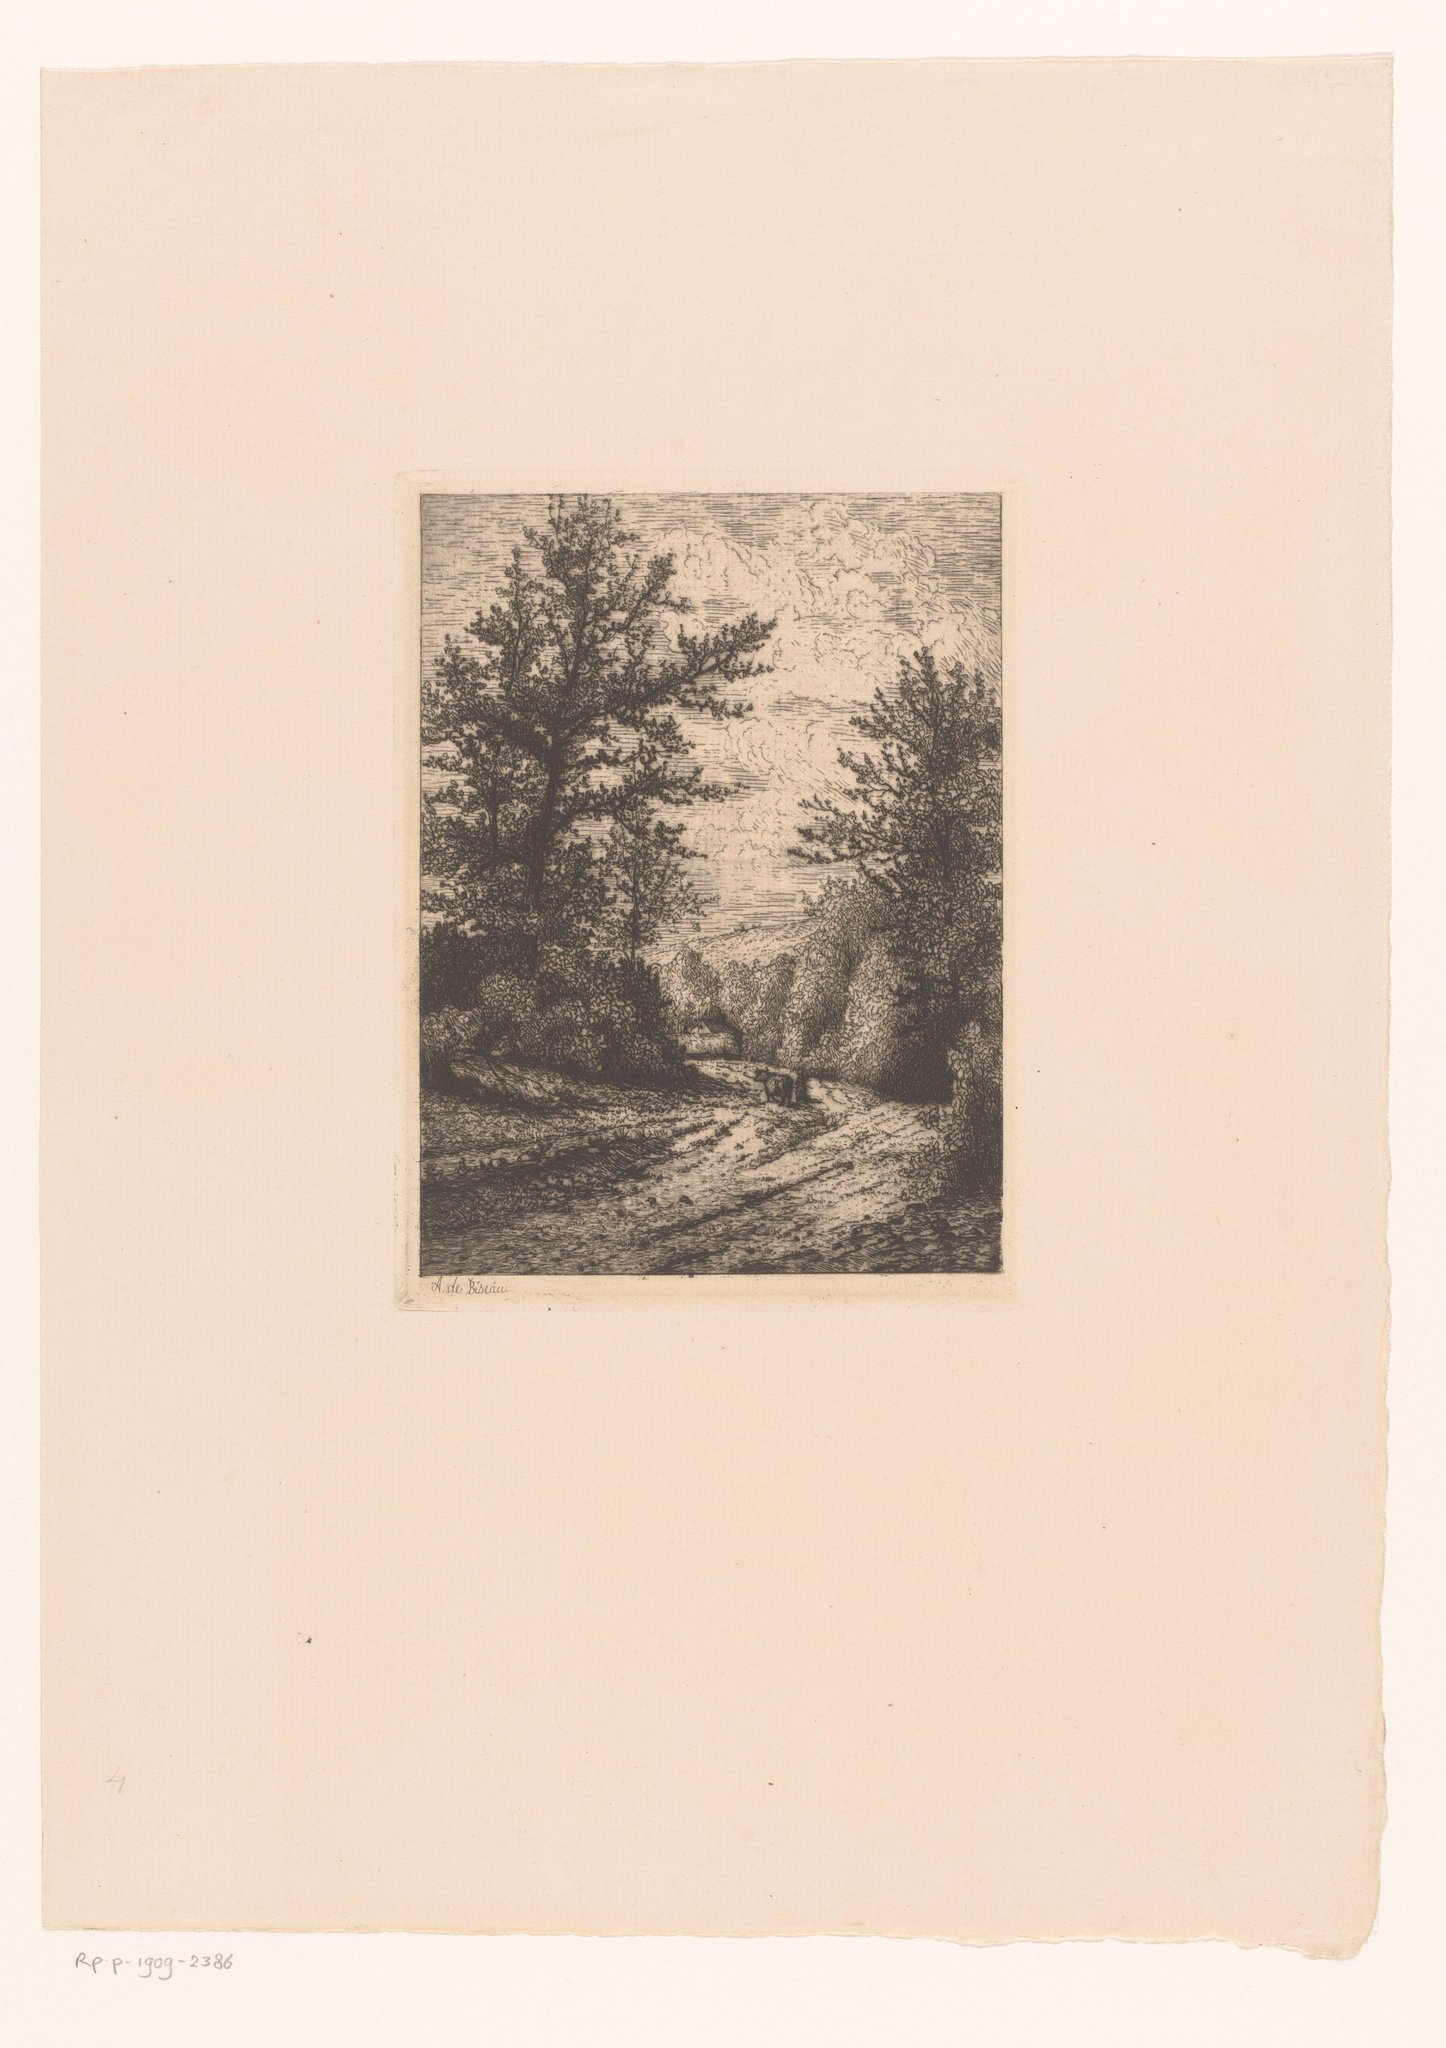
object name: print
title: Landschap met vrouw en koe op een pad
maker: aristide de biseau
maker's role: print maker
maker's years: 1844-1883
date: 1854-1883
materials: paper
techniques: drypoint, etching, intaglio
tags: cow, landscapes, farm or solitary house in landscape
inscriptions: collector's mark: Lugt 2228